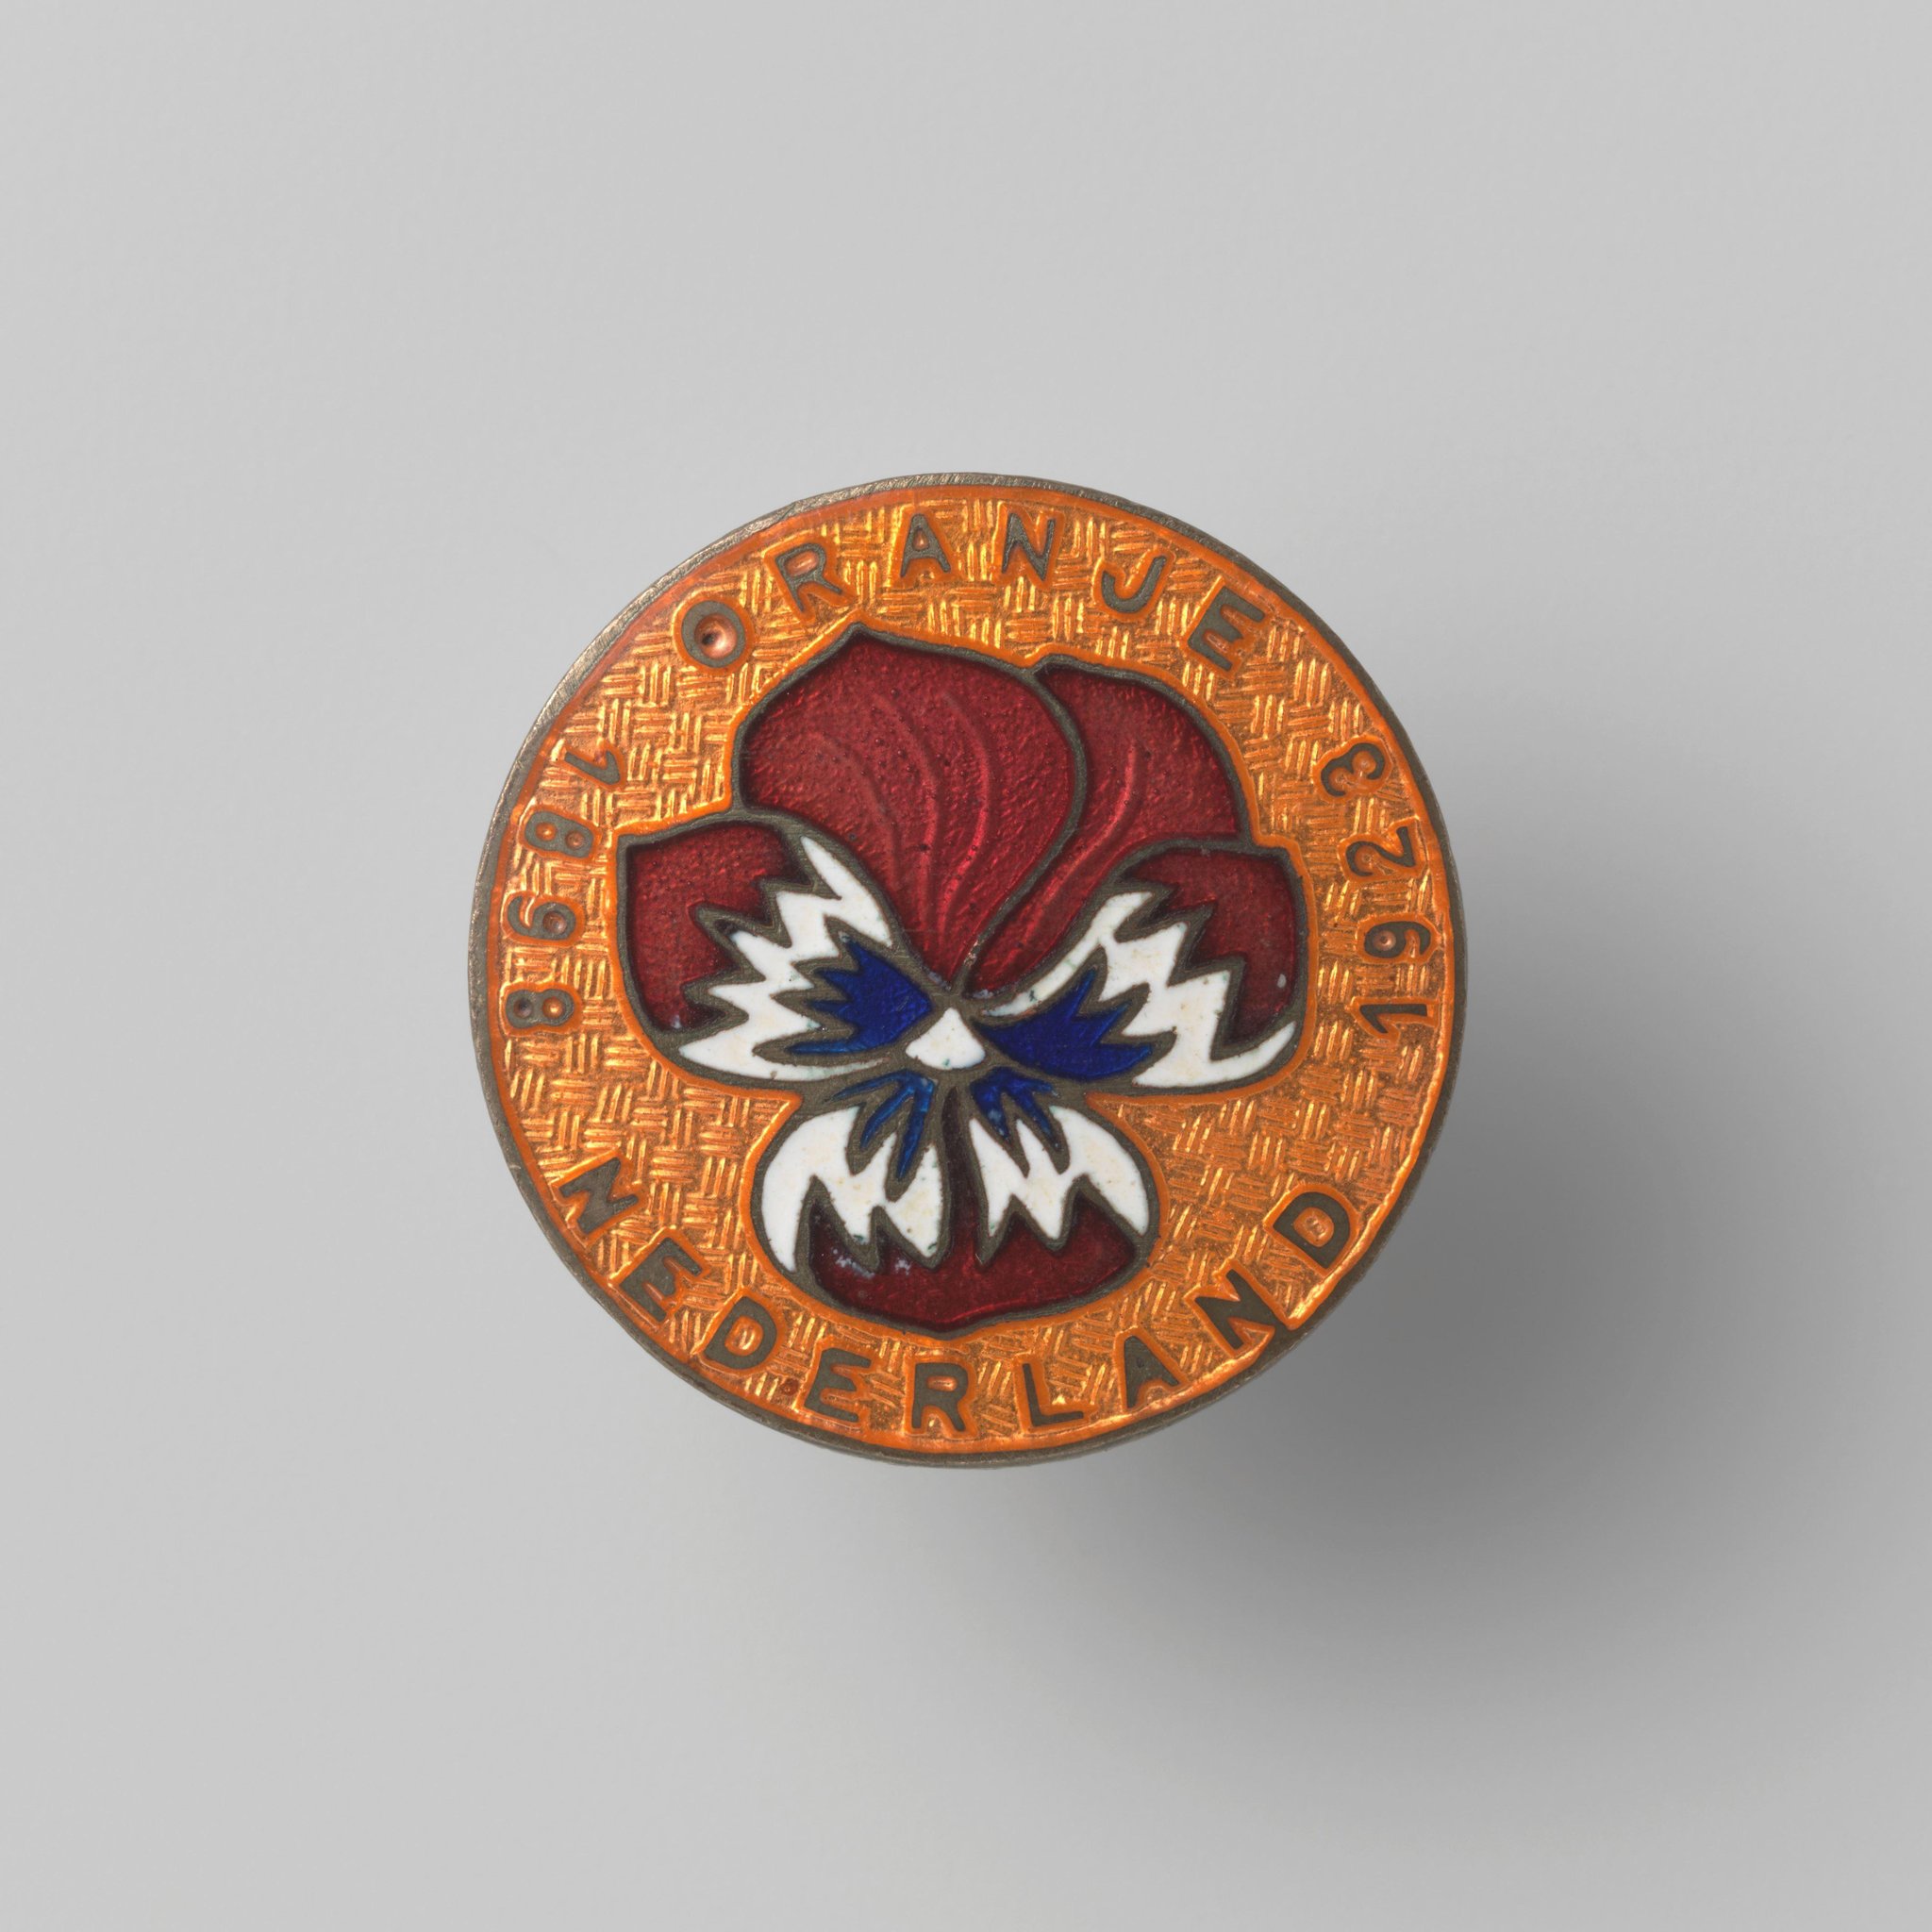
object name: brooch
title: Broche ter gelegenheid van het vijfentwintigjarig regeringsjubileum van Koningin Wilhelmina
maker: Anonymous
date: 1923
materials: metal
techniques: enameling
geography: netherlands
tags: berlin, the hague, wilhelmina frederica louisa (koningin der nederlanden)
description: Broche ter gelegenheid van het regeringsjubileum van Koningin Wilhelmina van geëmailleerd metaal.